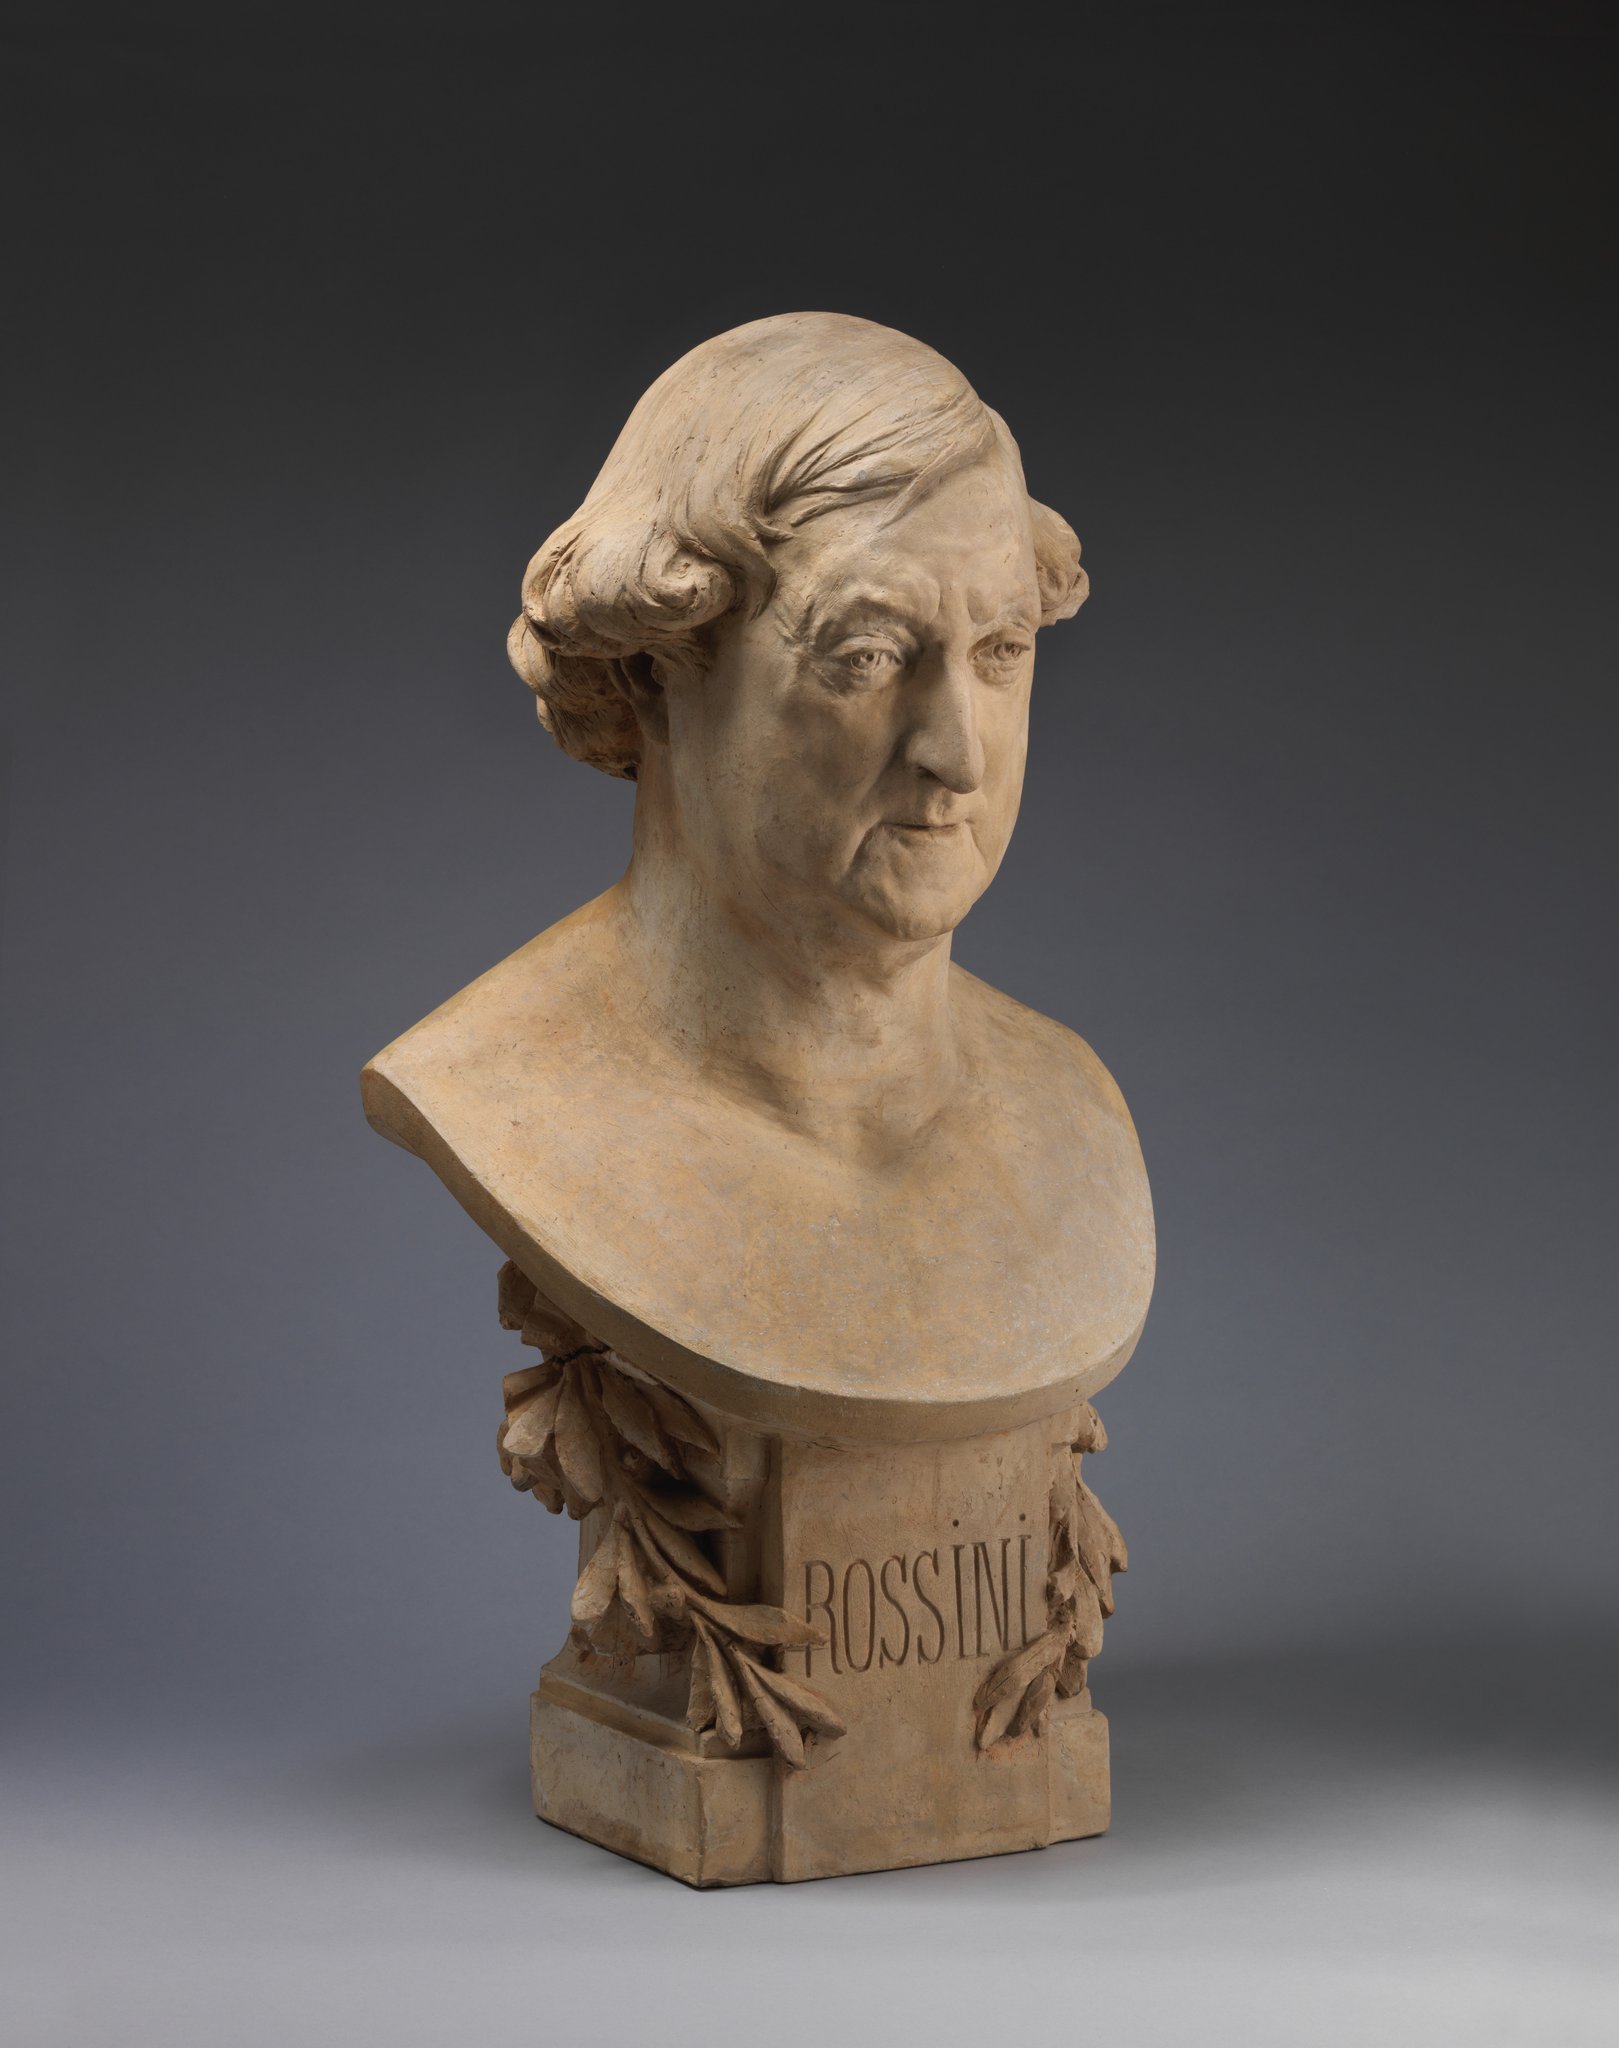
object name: bust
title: Gioachino Rossini (1792–1868)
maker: albert-ernest carrier-belleuse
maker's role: artist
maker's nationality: french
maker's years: 1824-1887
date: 1865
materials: terracotta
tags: men,portraits